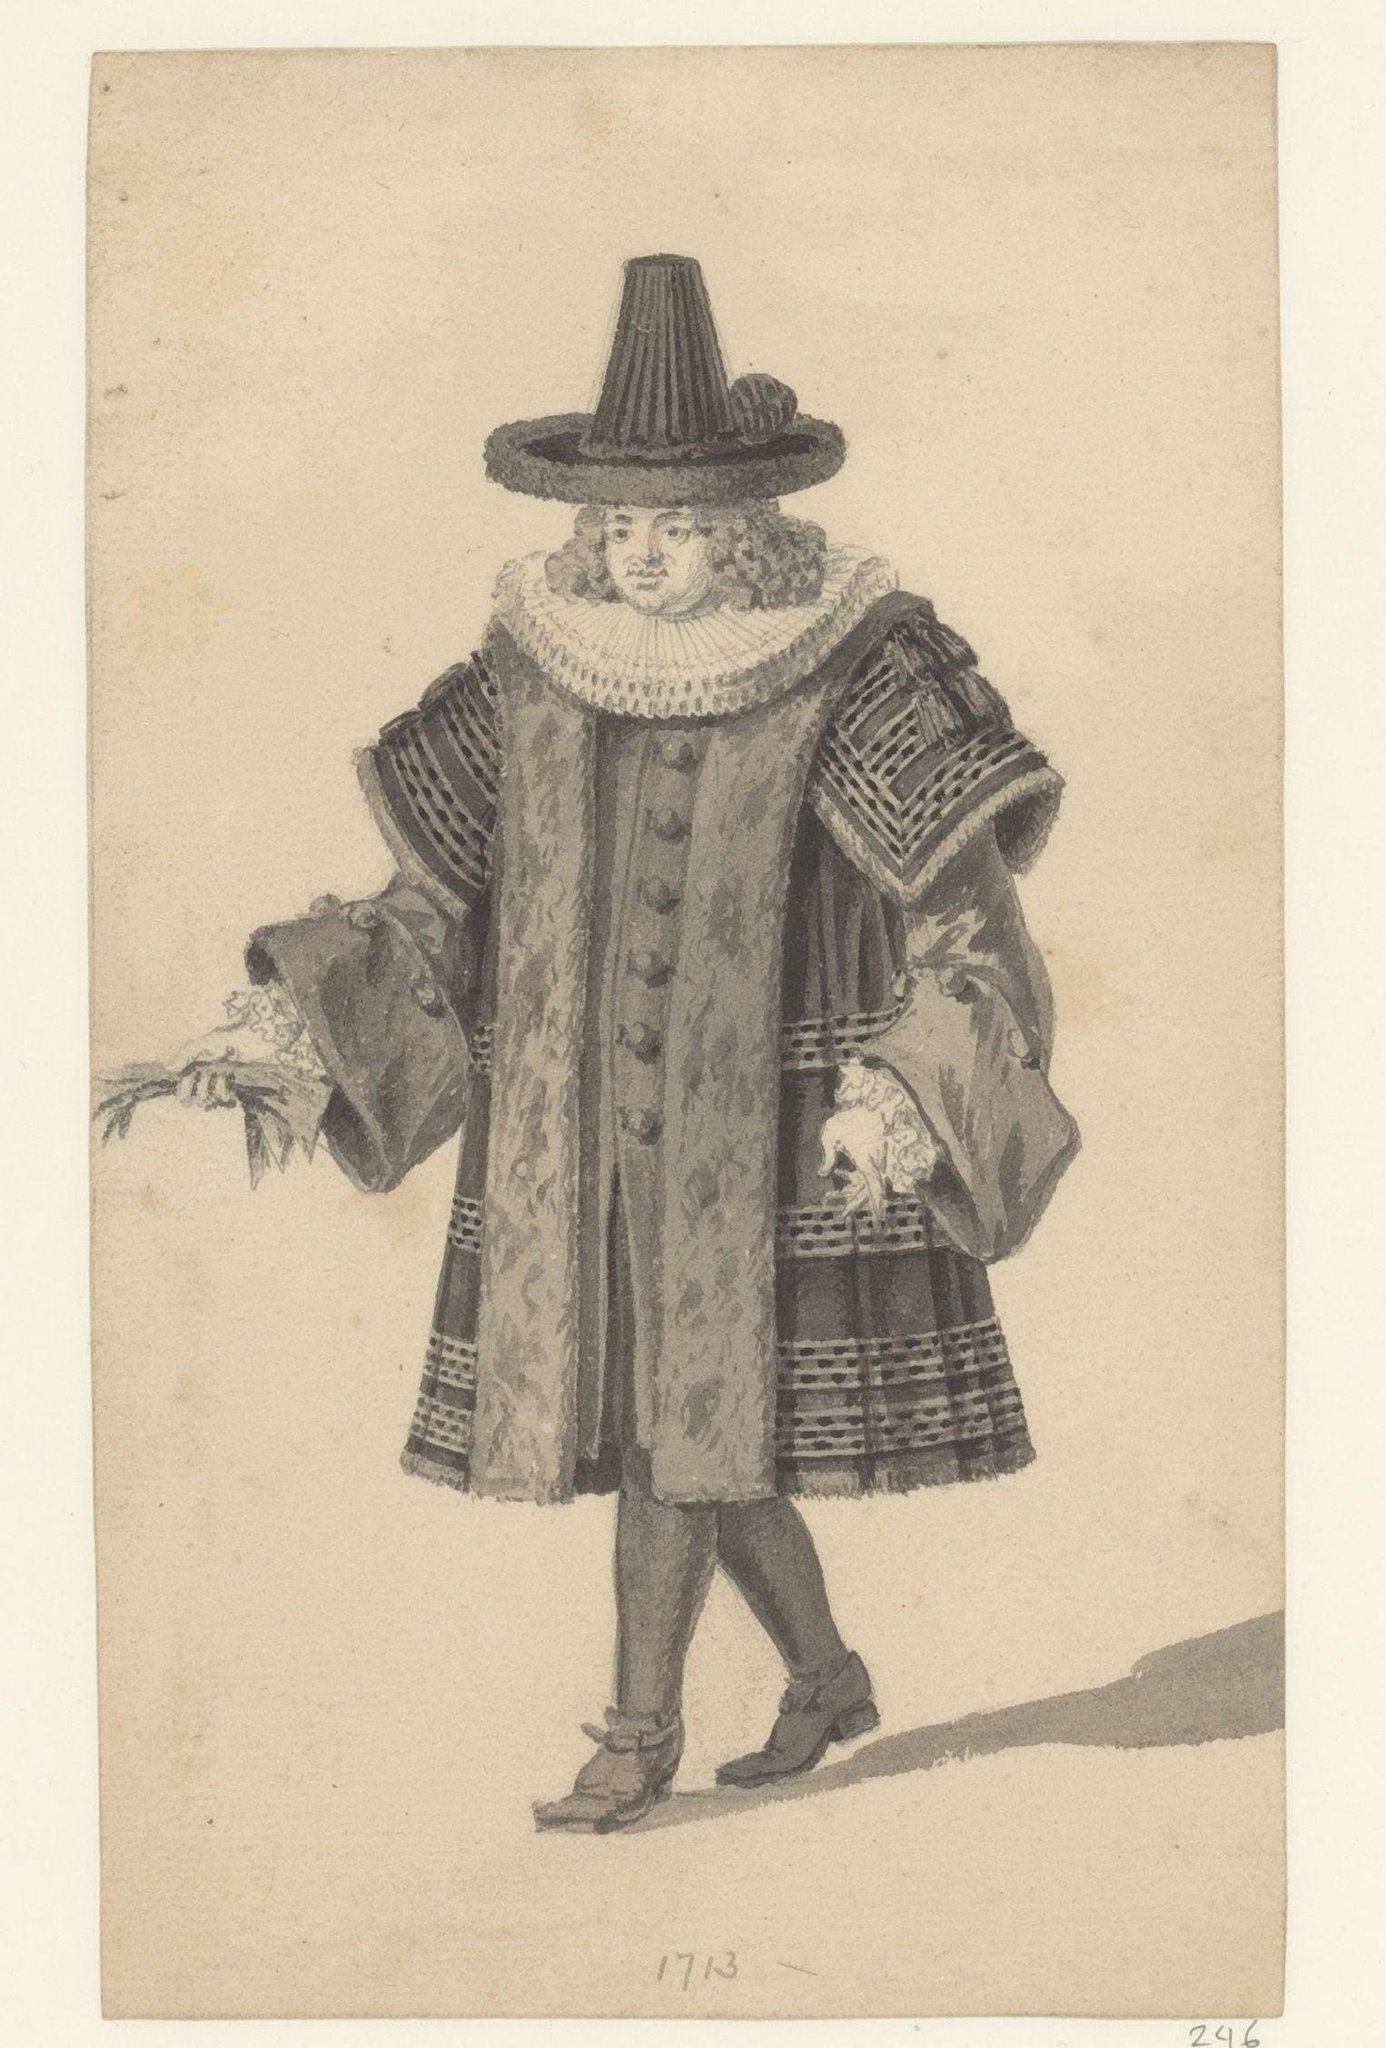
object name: drawing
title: Welgestelde man, 1713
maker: Anonymous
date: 1800-1899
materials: ink, paper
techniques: brush, pen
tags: stage costume, clothes, costume, coat, cape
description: Onderwerpsrubrieken binnen de Atlas Zeden en Gewoonten: Tooneel, Varia (Beheer en financiën).